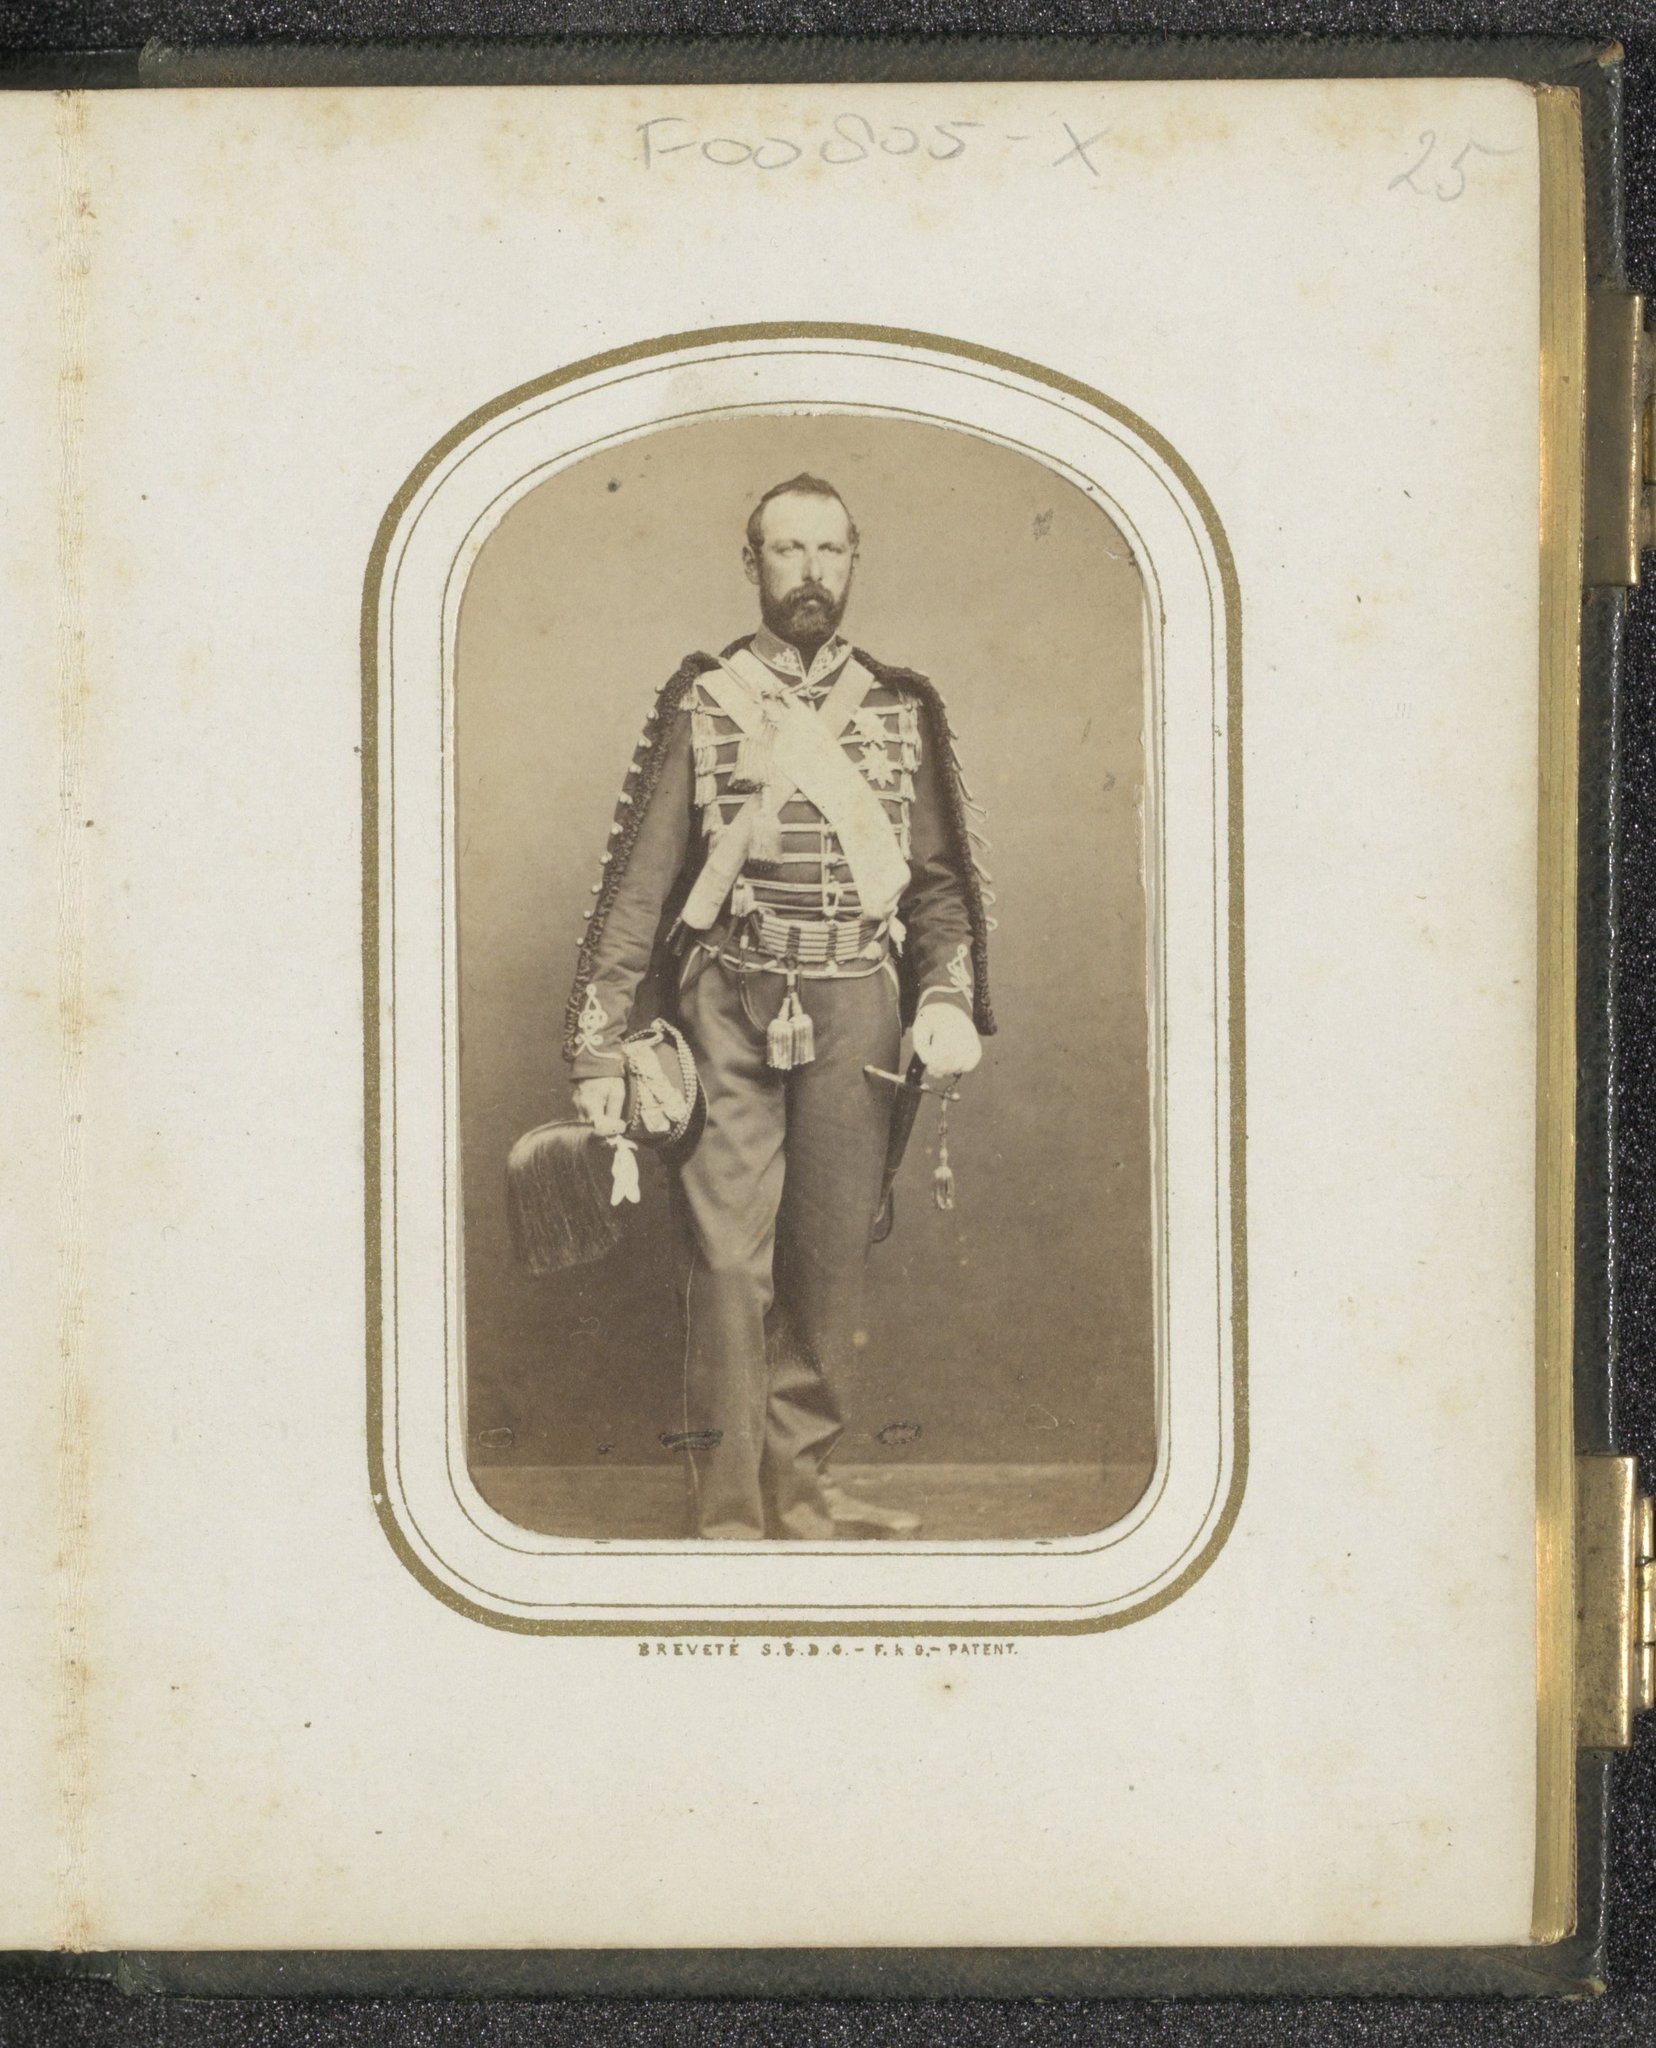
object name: carte de visite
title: Portret van Karel XV, koning van Zweden en Noorwegen, in militair kostuum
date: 1855-1872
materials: cardboard, paper, photographic support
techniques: albumen print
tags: karel xv (koning van zweden en noorwegen), hacking and thrusting weapons (with name), historical persons, head-gear: hat (+ men's clothes), medals and other marks of military honour, ruler, sovereign, (military) uniforms, beard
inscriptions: address: ‘Boulevart des Capucines 3, Paris’, inscription: ‘Koning v. Sweden’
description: Onderdeel van Fotoalbum met 29 foto's van Nederlandse vorsten.